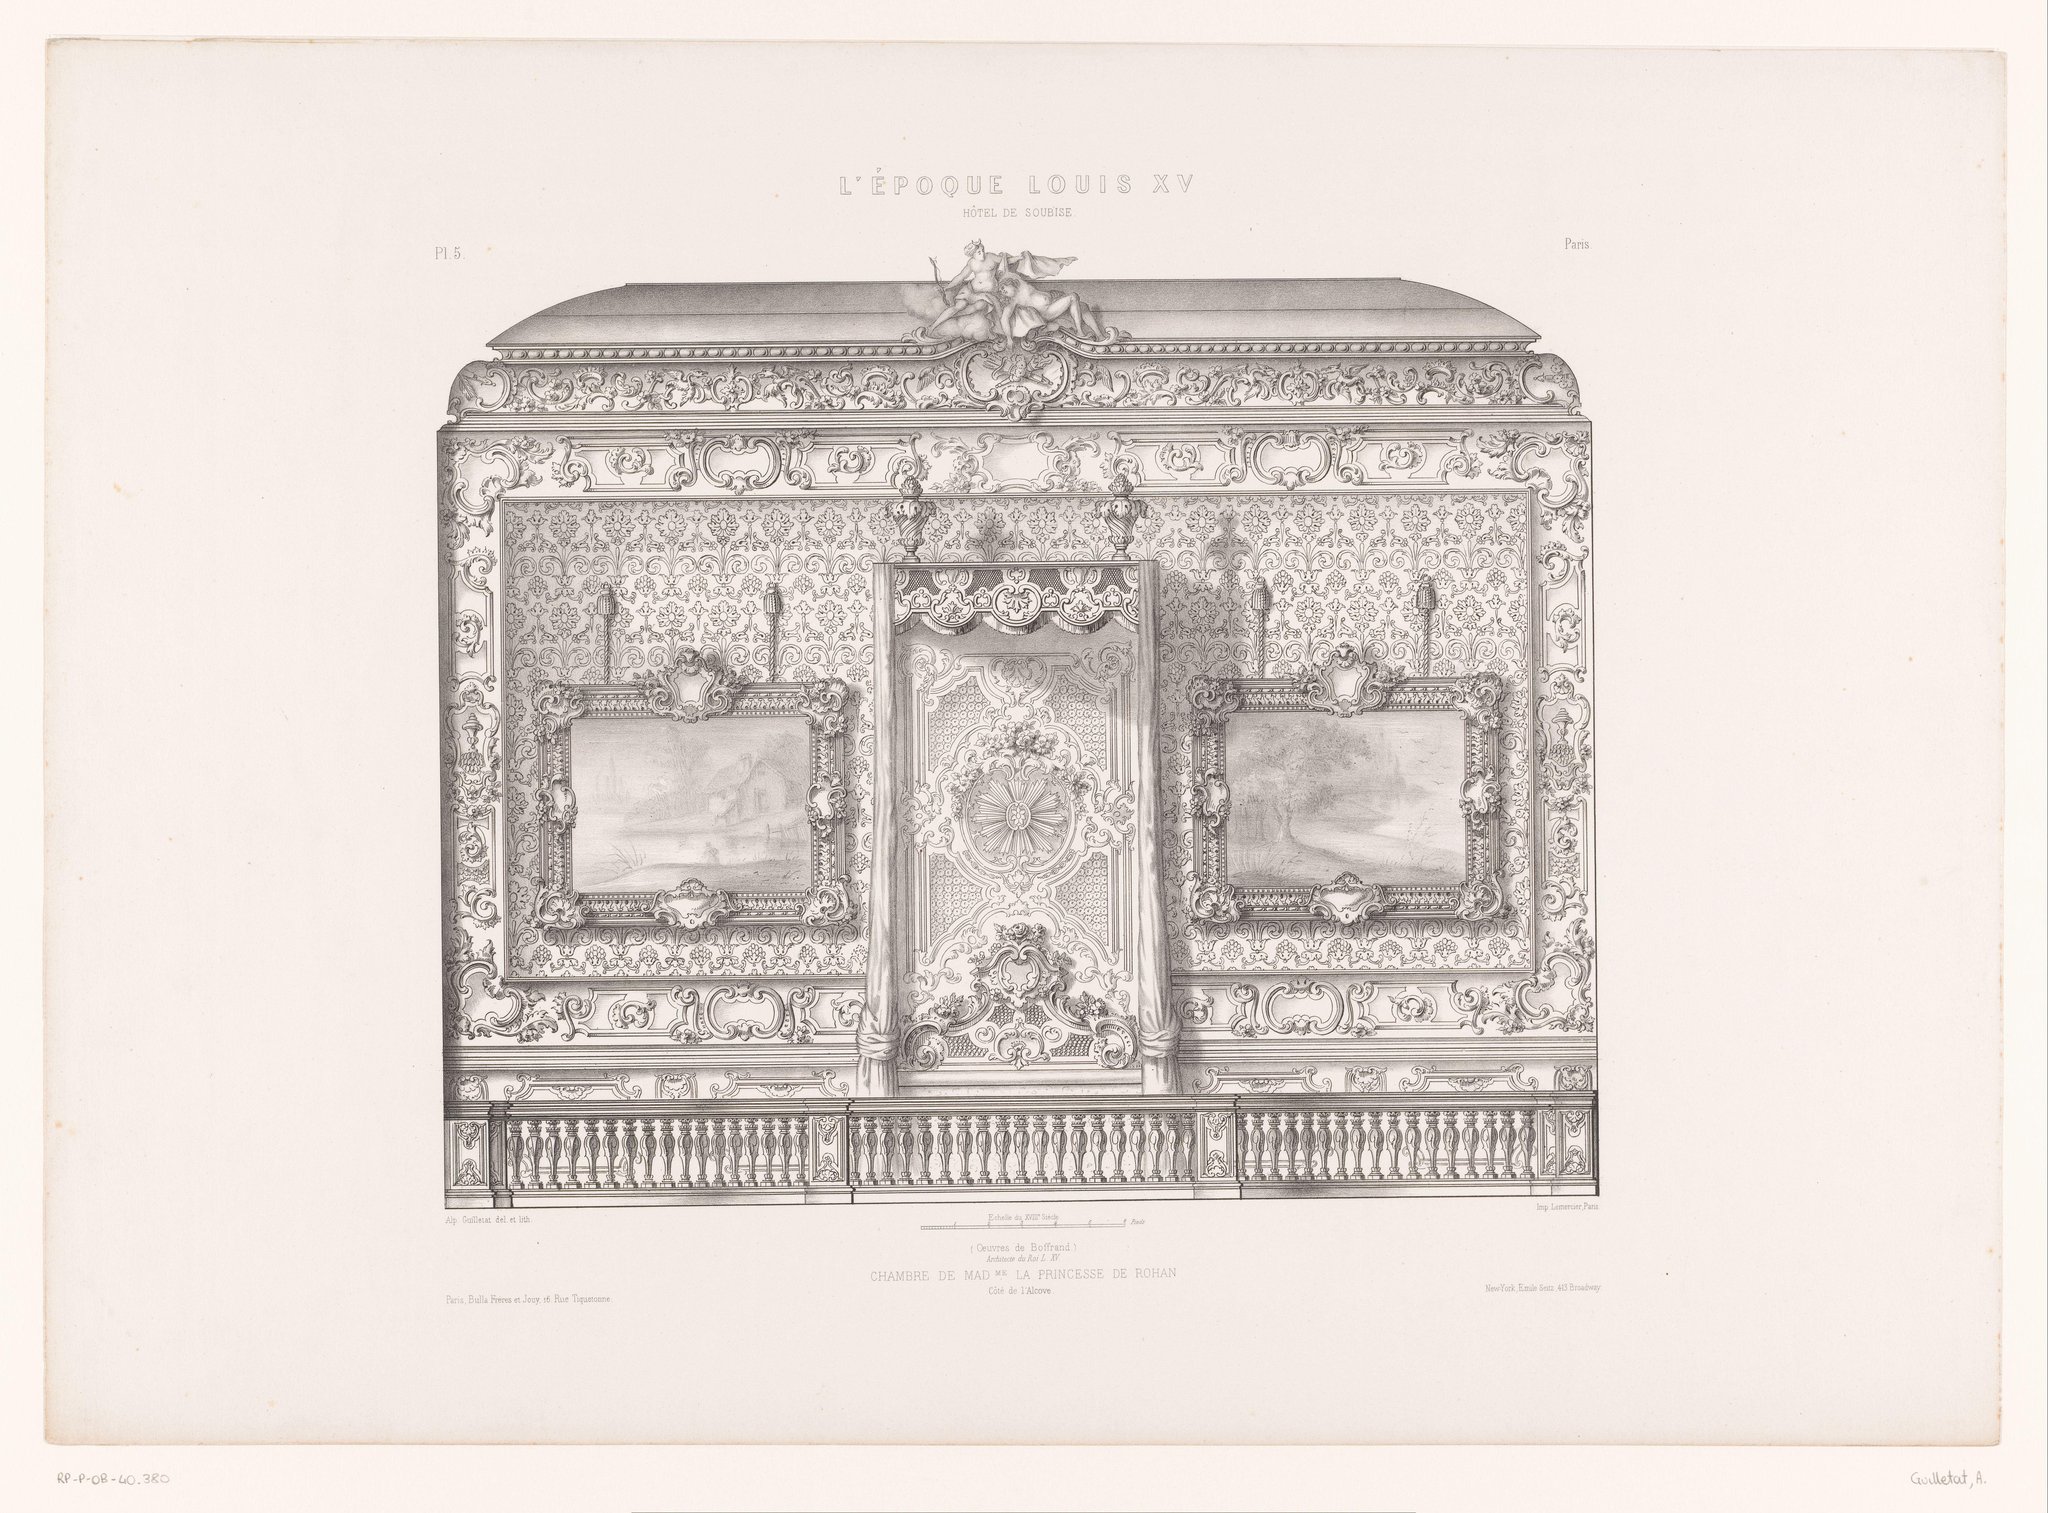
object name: print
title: L'Époque Louis XV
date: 1859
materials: paper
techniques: lithograph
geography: new york city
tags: decorations (interior of the house), interior ~ architectural design or model